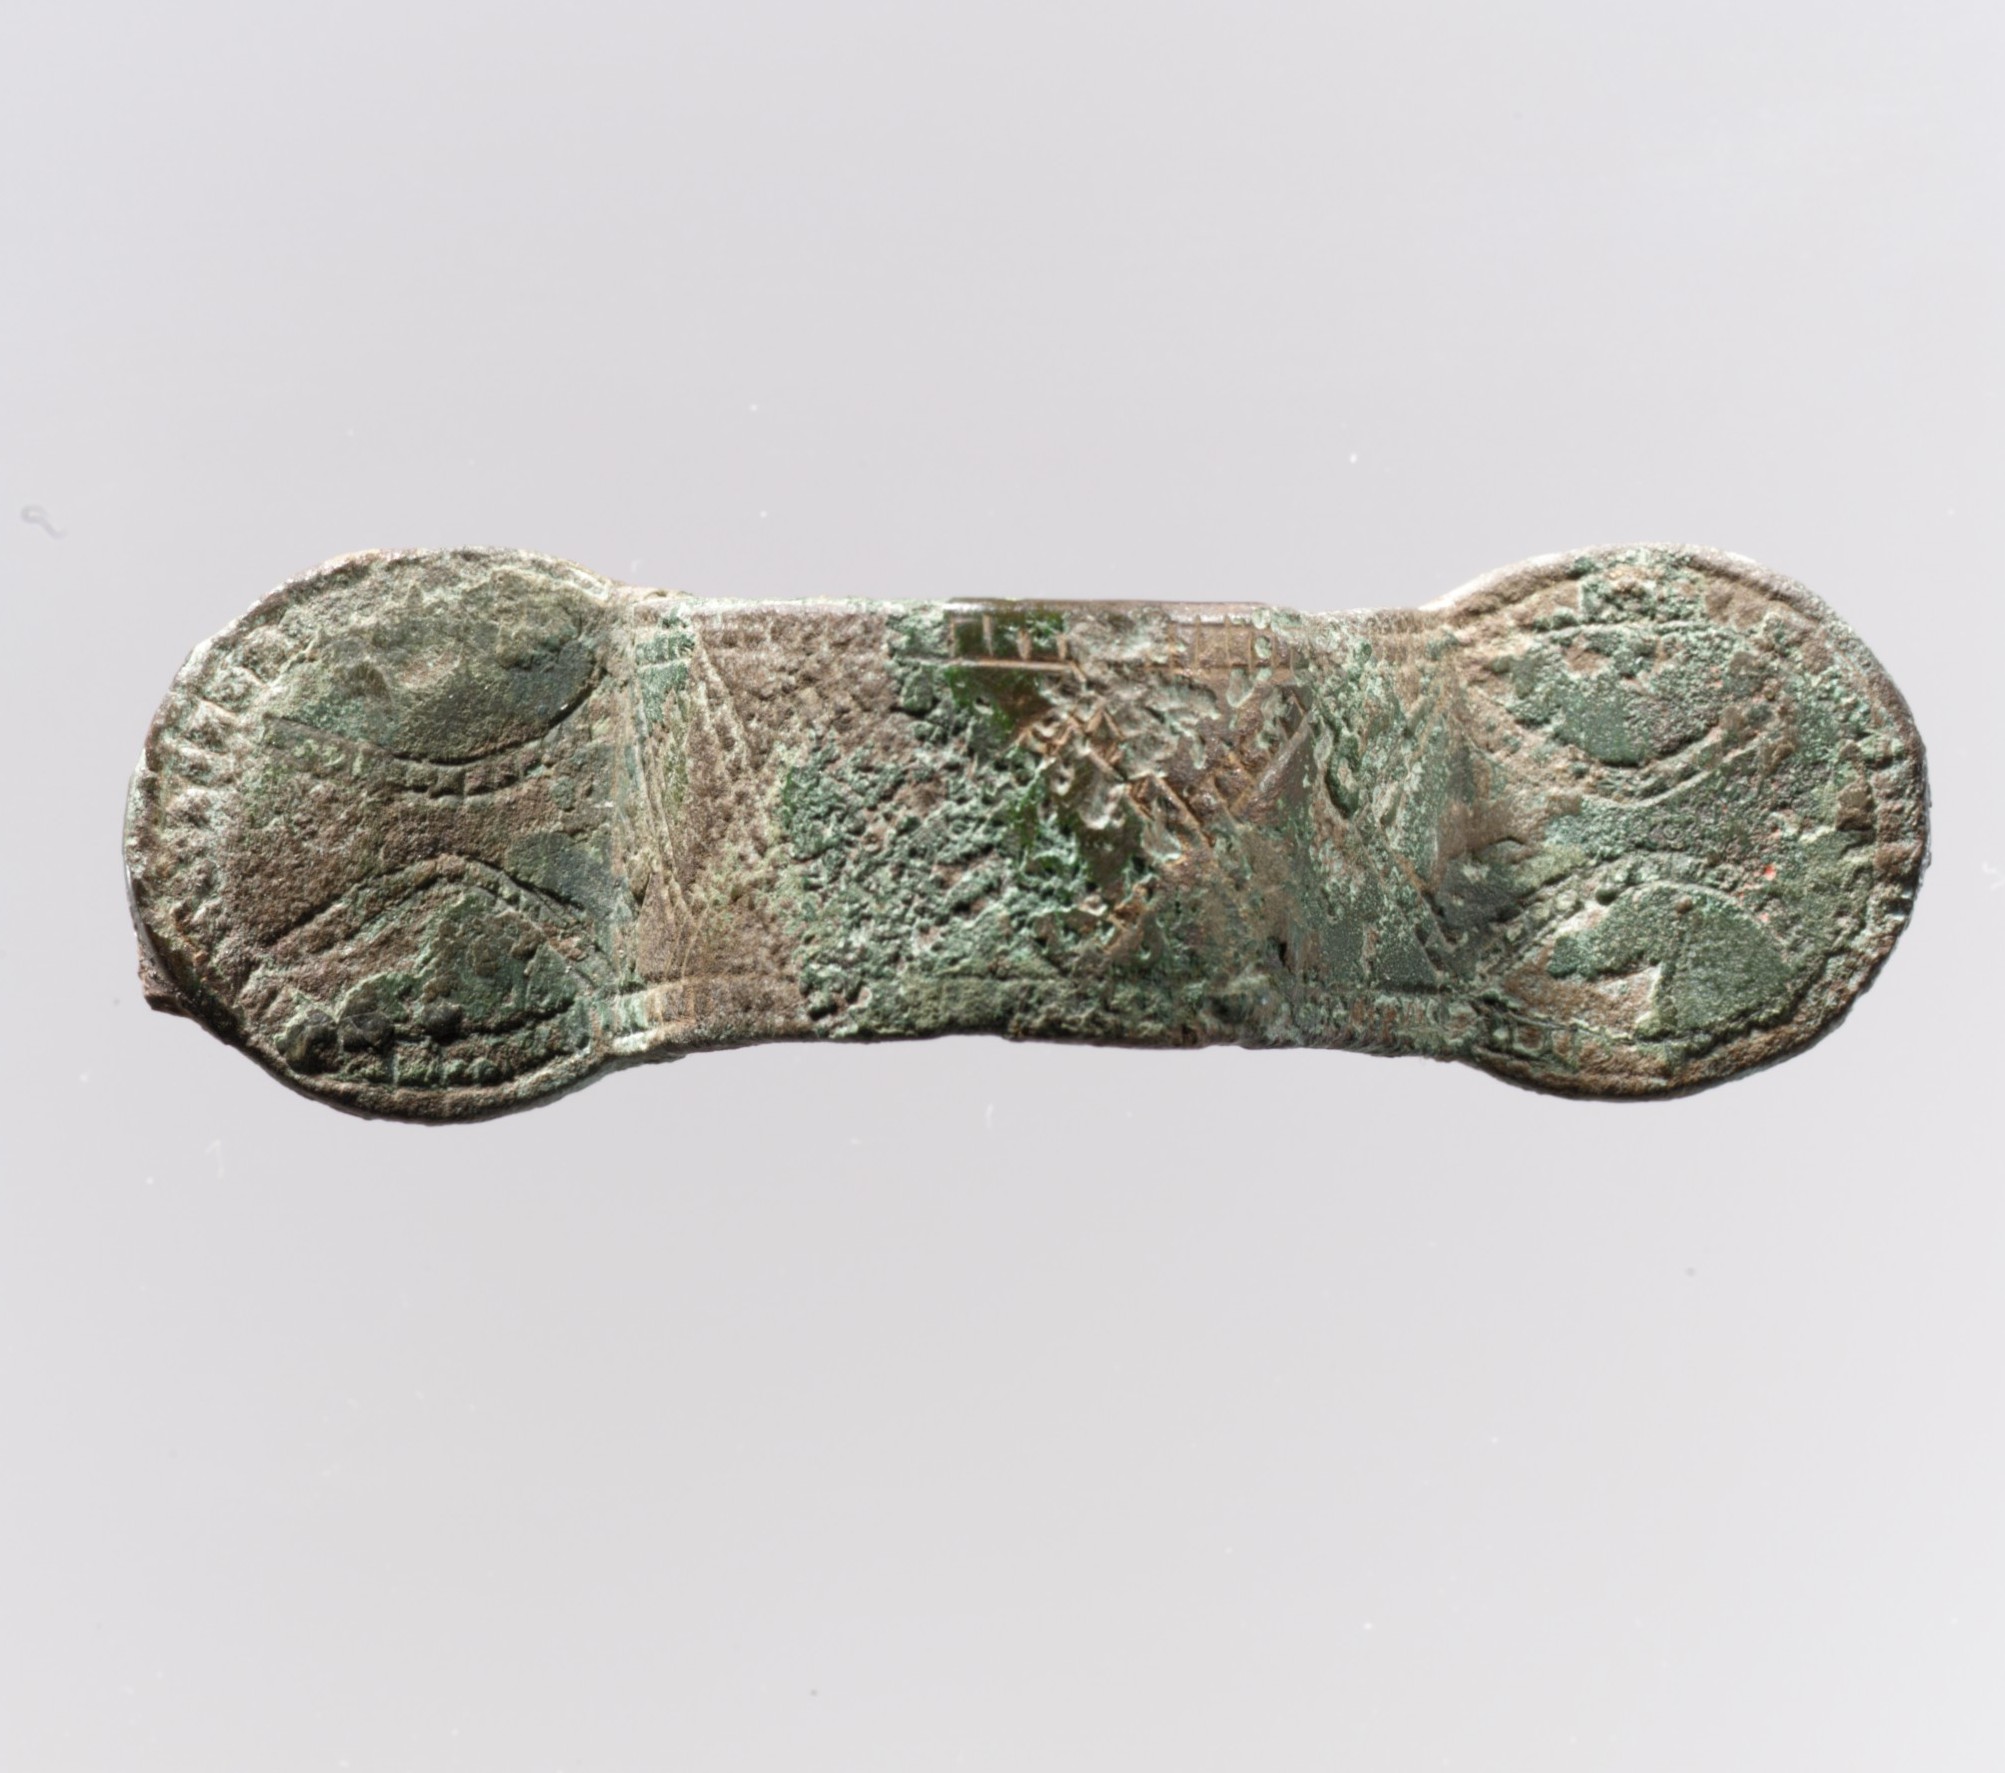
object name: brooch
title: Equal-Arm Brooch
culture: frankish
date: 650-750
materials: copper alloy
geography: germany